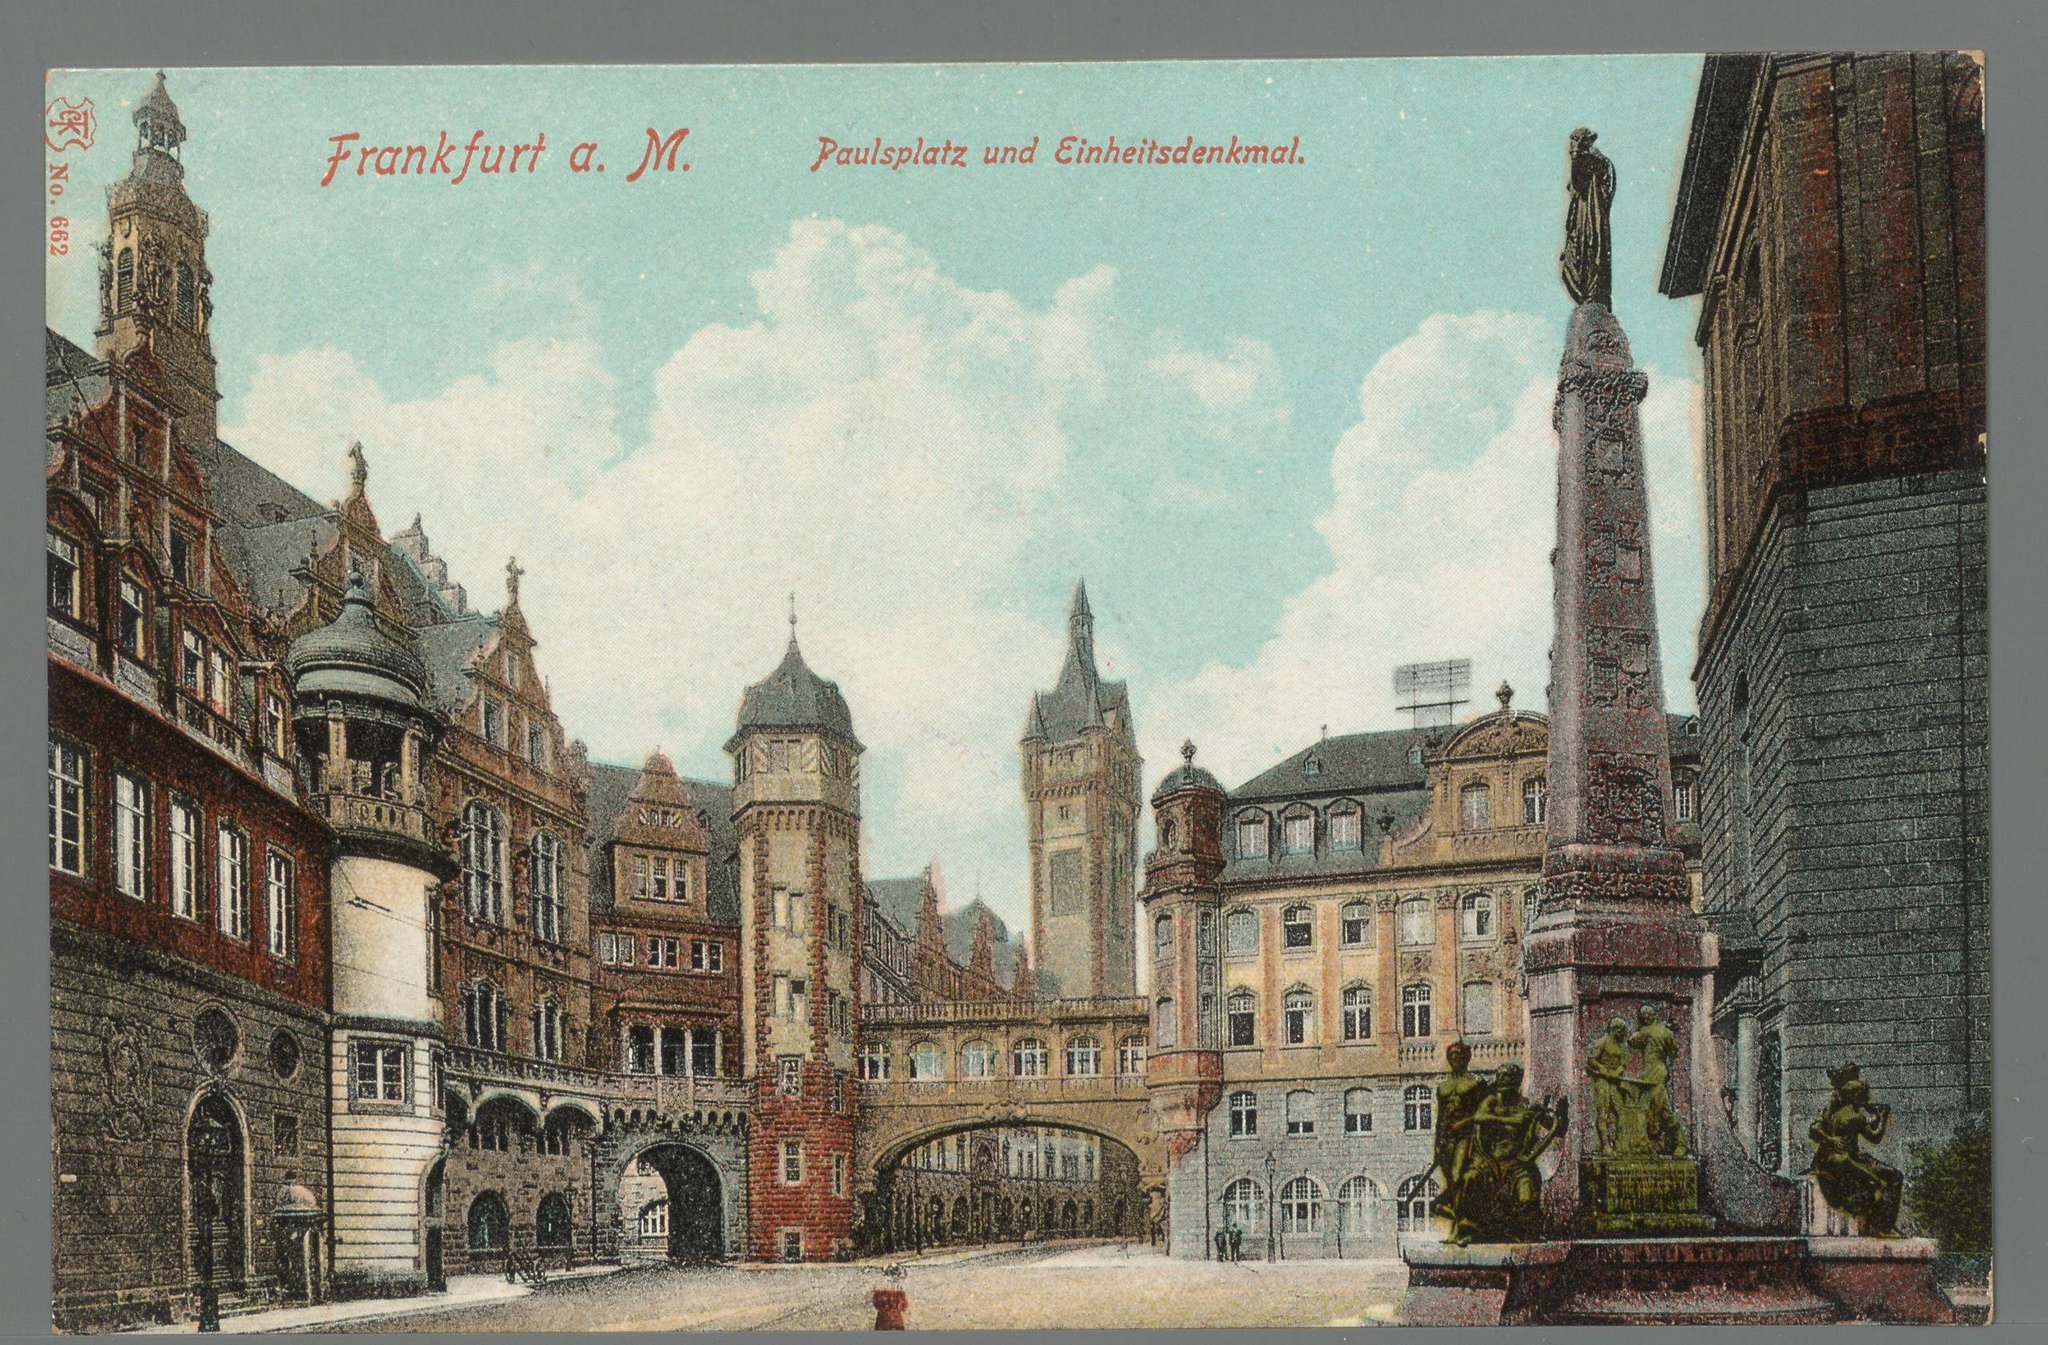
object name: photomechanical print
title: Frankfurt a. M. Paulsplatz und Einheitsdenkmal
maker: Anonymous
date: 1905-1908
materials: cardboard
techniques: photograph, lithograph, writing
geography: frankfurt am main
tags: square, place, circus, etc., monument, statue